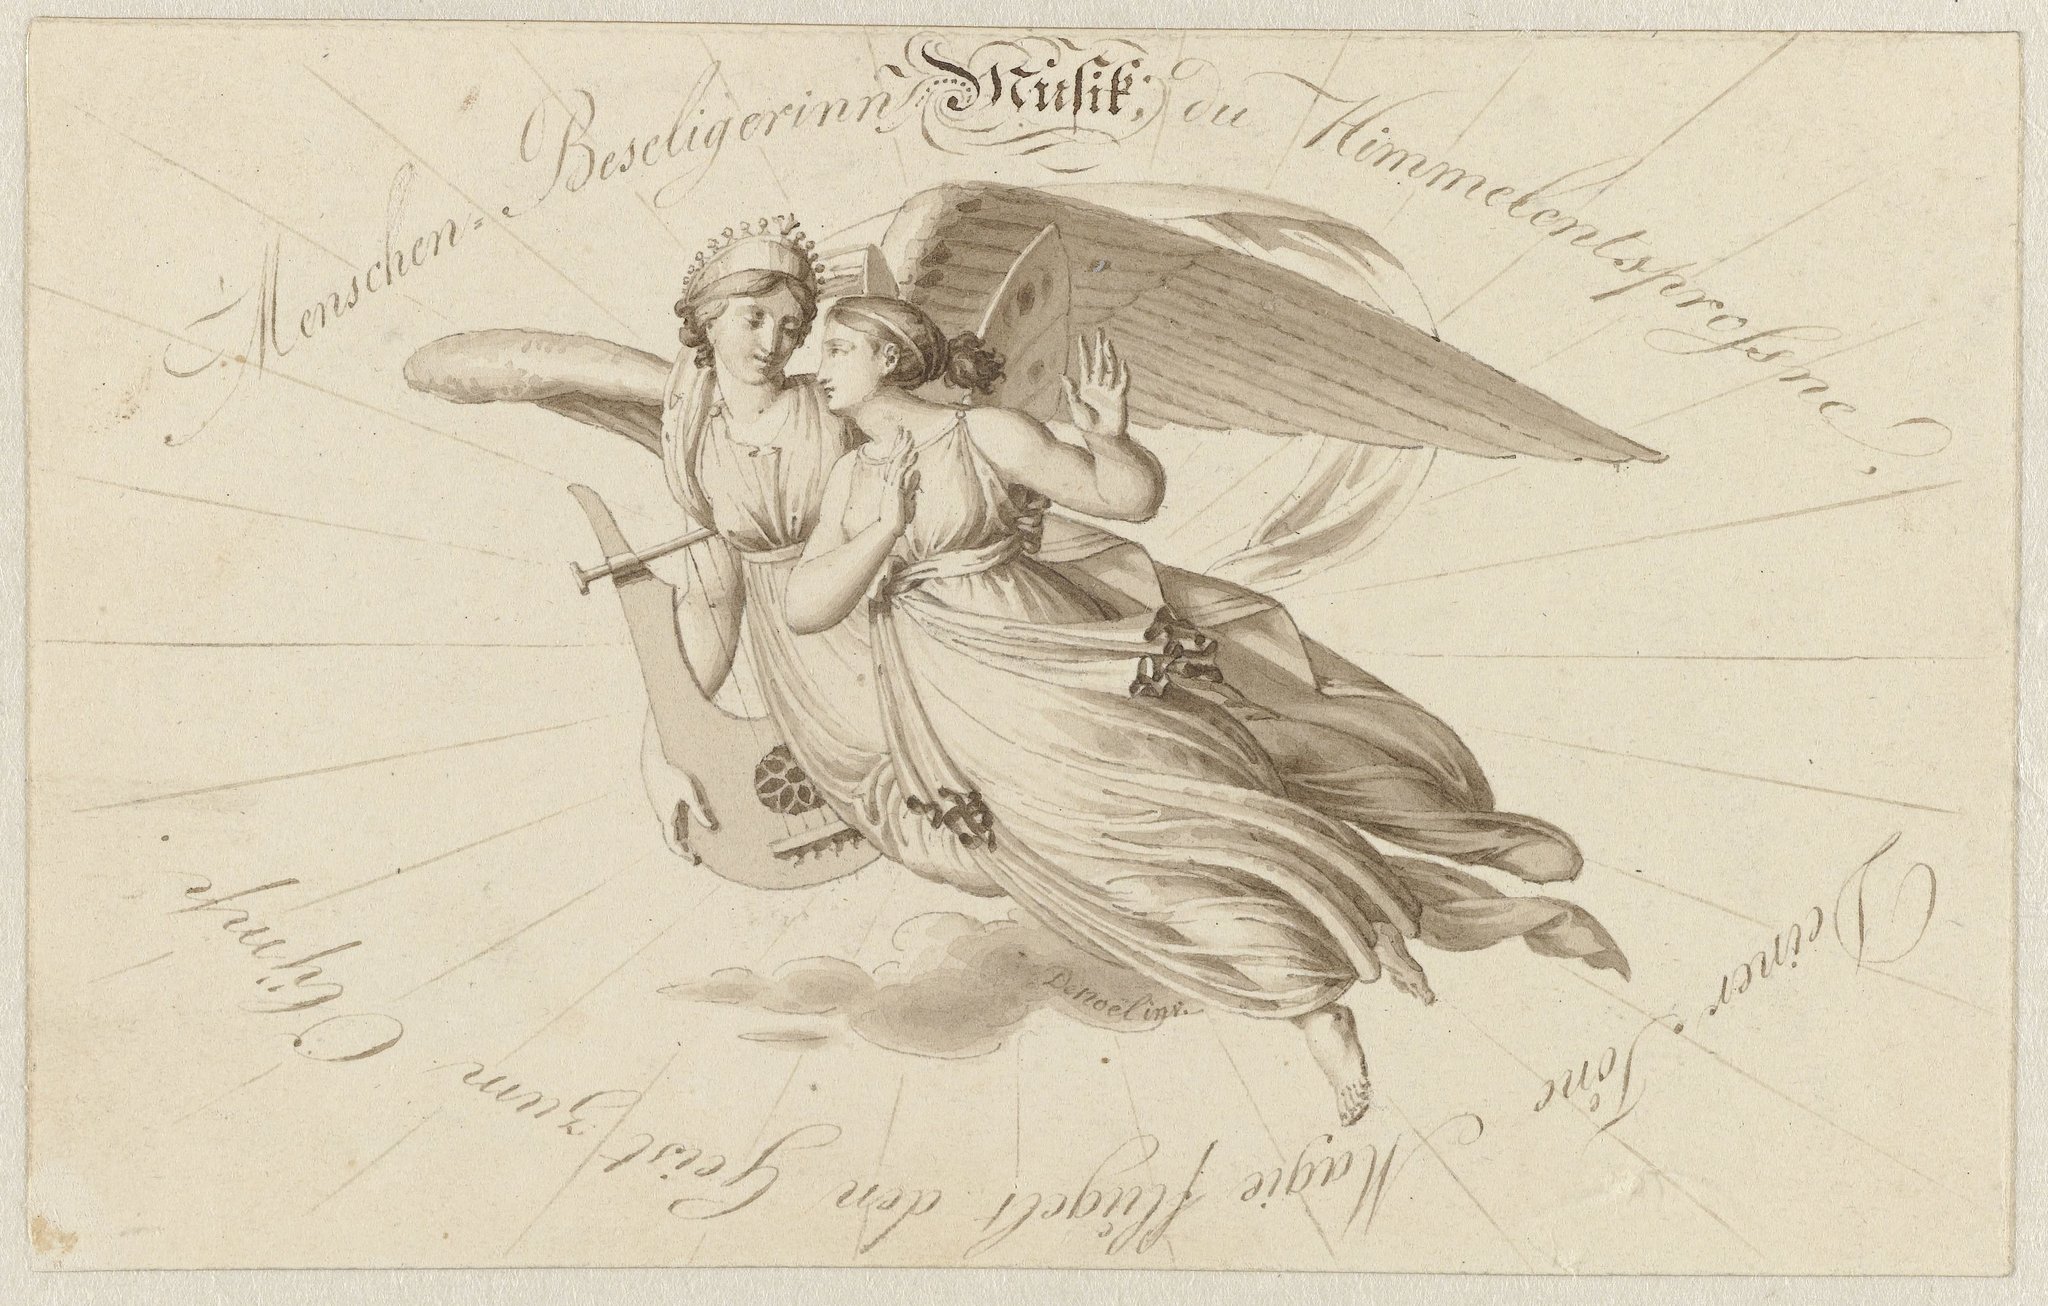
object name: drawing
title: De Muziek verheft de Geest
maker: matthias joseph de noël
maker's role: draughtsman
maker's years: 1782-1849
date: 1792-1849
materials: ink, paper, pencil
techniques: brush, pen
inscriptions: signature: ‘De Noël inv.’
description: Blad uit het Album Amicorum van Josephus Augustinus Brentano.